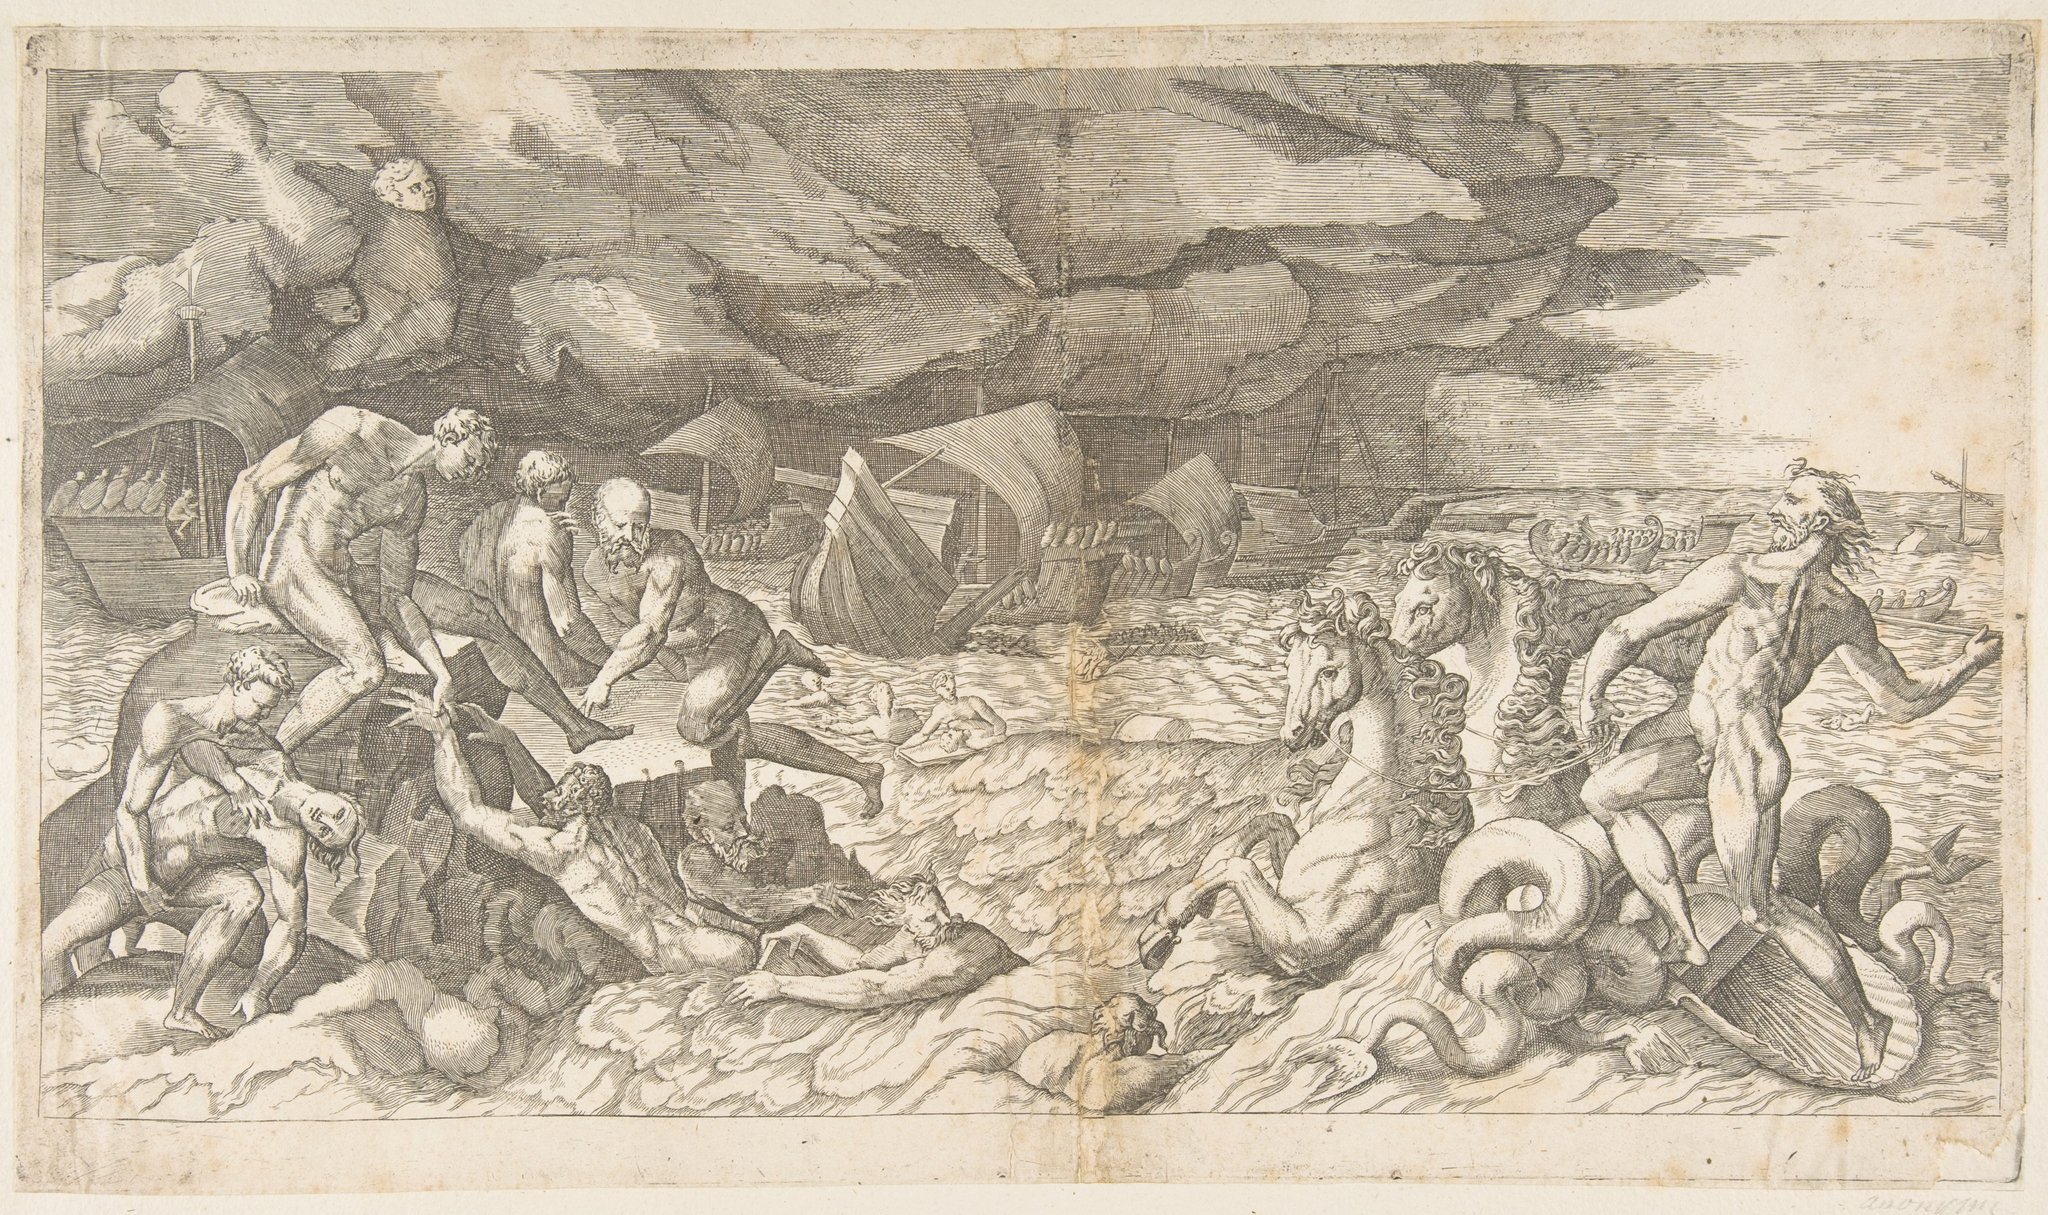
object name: print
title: Neptune calming the Tempest Aeolus raised against the Fleet of Aeneas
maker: giulio bonasone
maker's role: artist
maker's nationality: italian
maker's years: 1510-1576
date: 1531-1576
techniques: engraving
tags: aeneas,neptune,boats